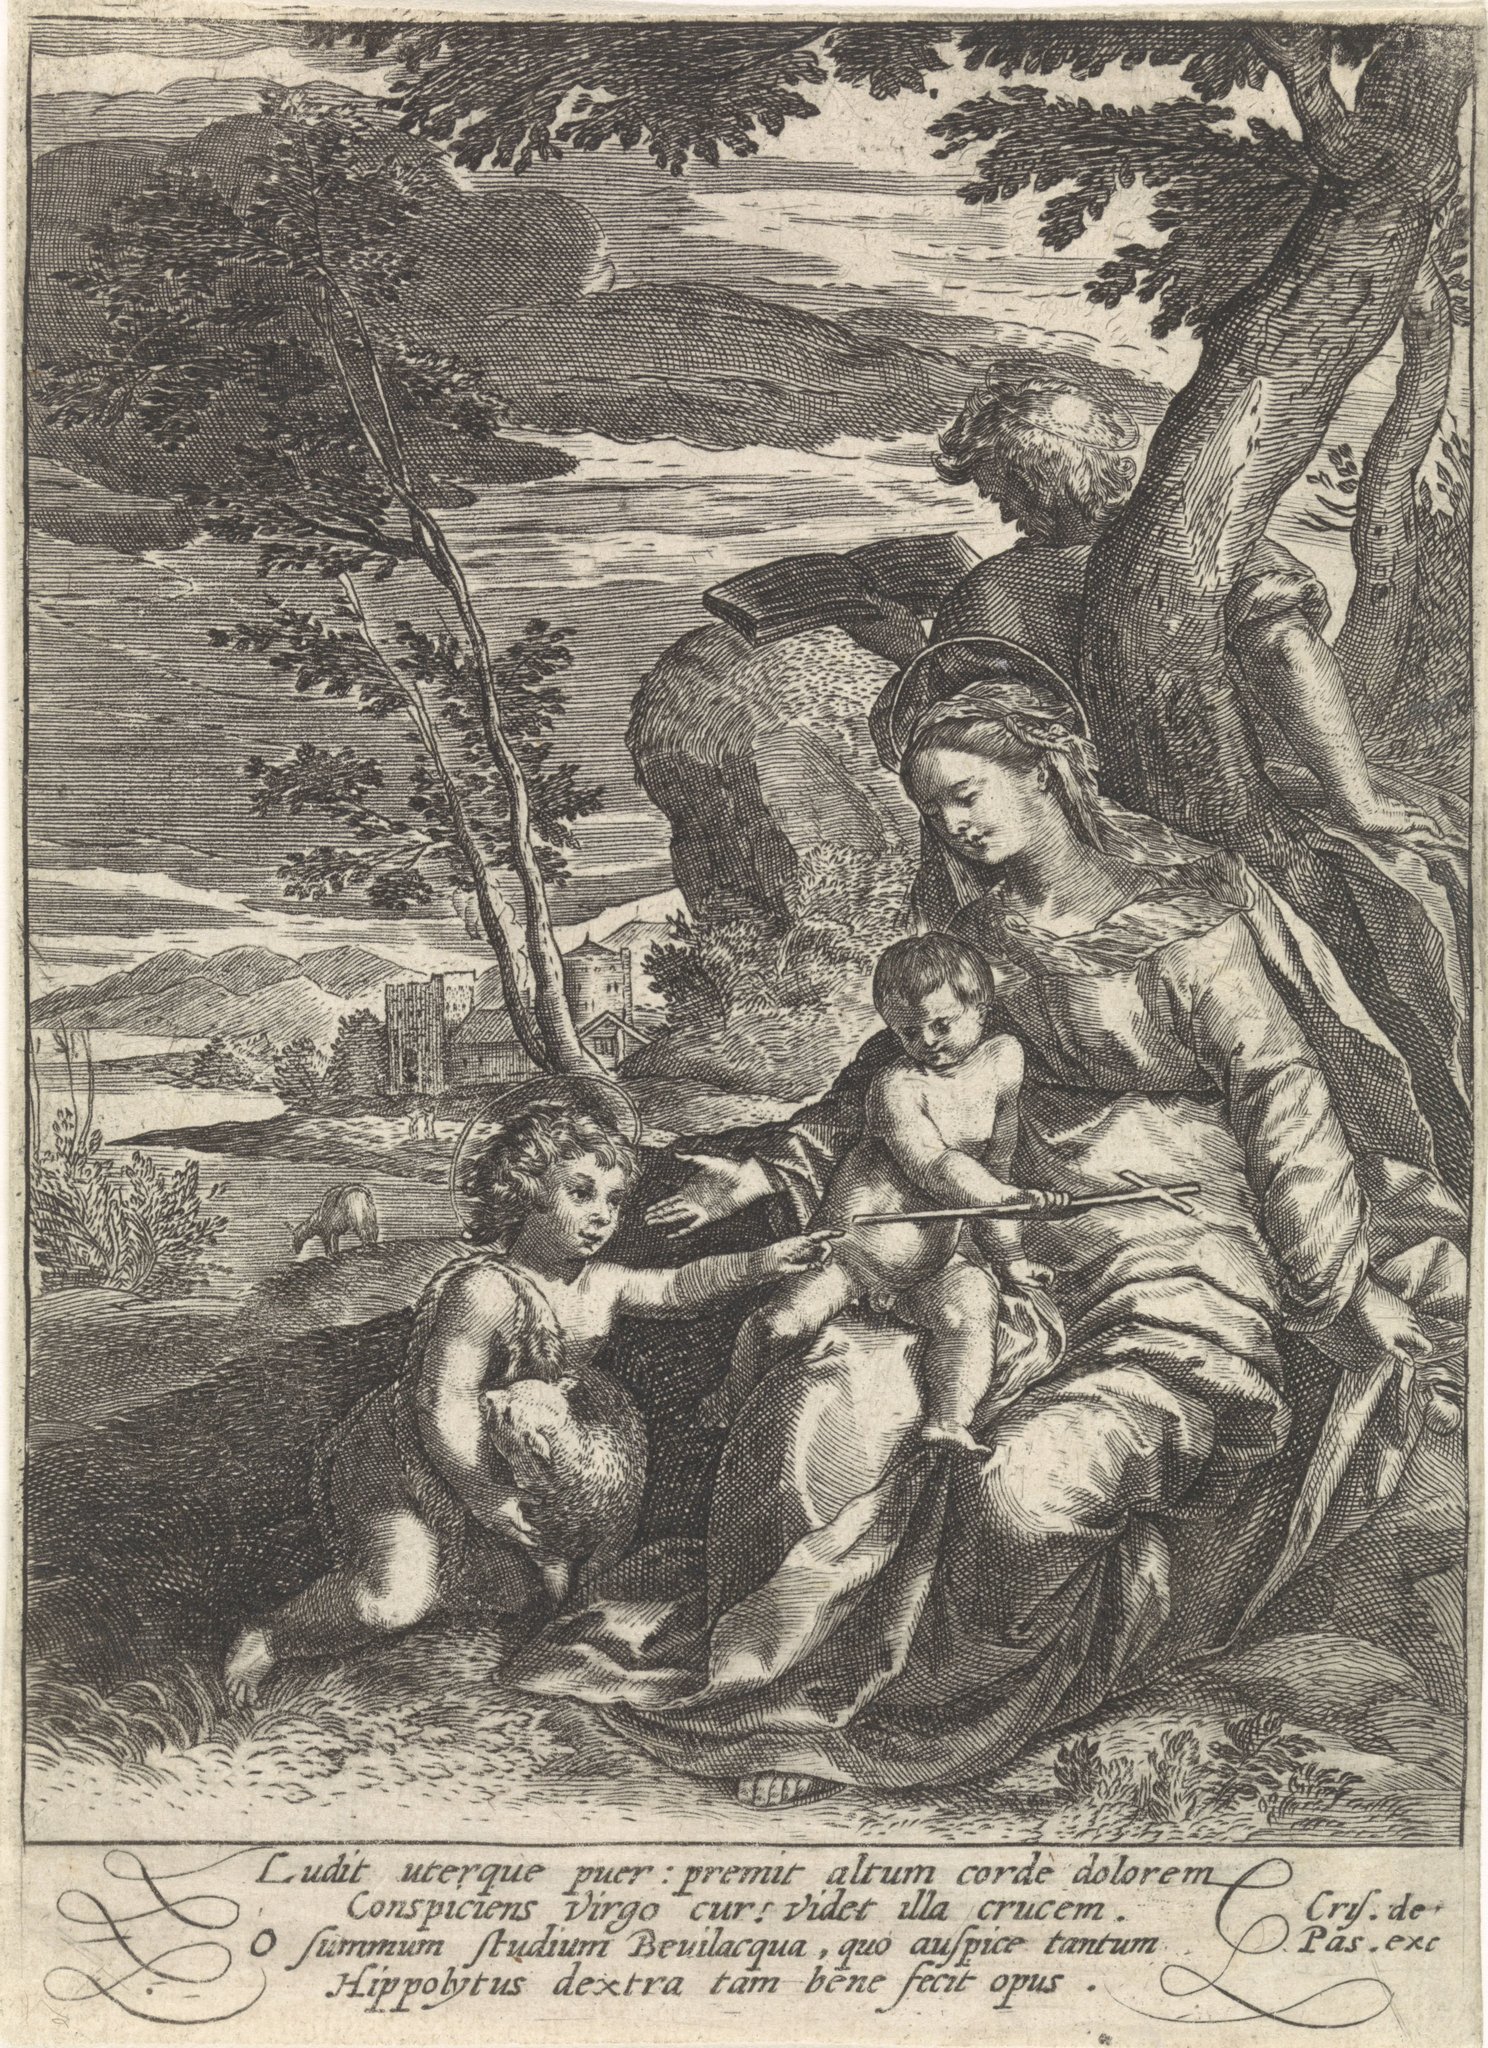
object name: print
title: De heilige familie en Johannes de Doper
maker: crispijn van de passe (i)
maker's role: draughtsman, print maker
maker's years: 1564-1637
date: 1574-1637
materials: paper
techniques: engraving, etching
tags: holy family, and derived representations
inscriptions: collector's mark: Lugt 2228, collector's mark: Lugt 1337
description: Maria zit met het Christuskind op schoot, ze reikt naar Johannes de Doper. Jozef staat achter de boom. In de marge een vierregelig onderschrift in het Latijn.